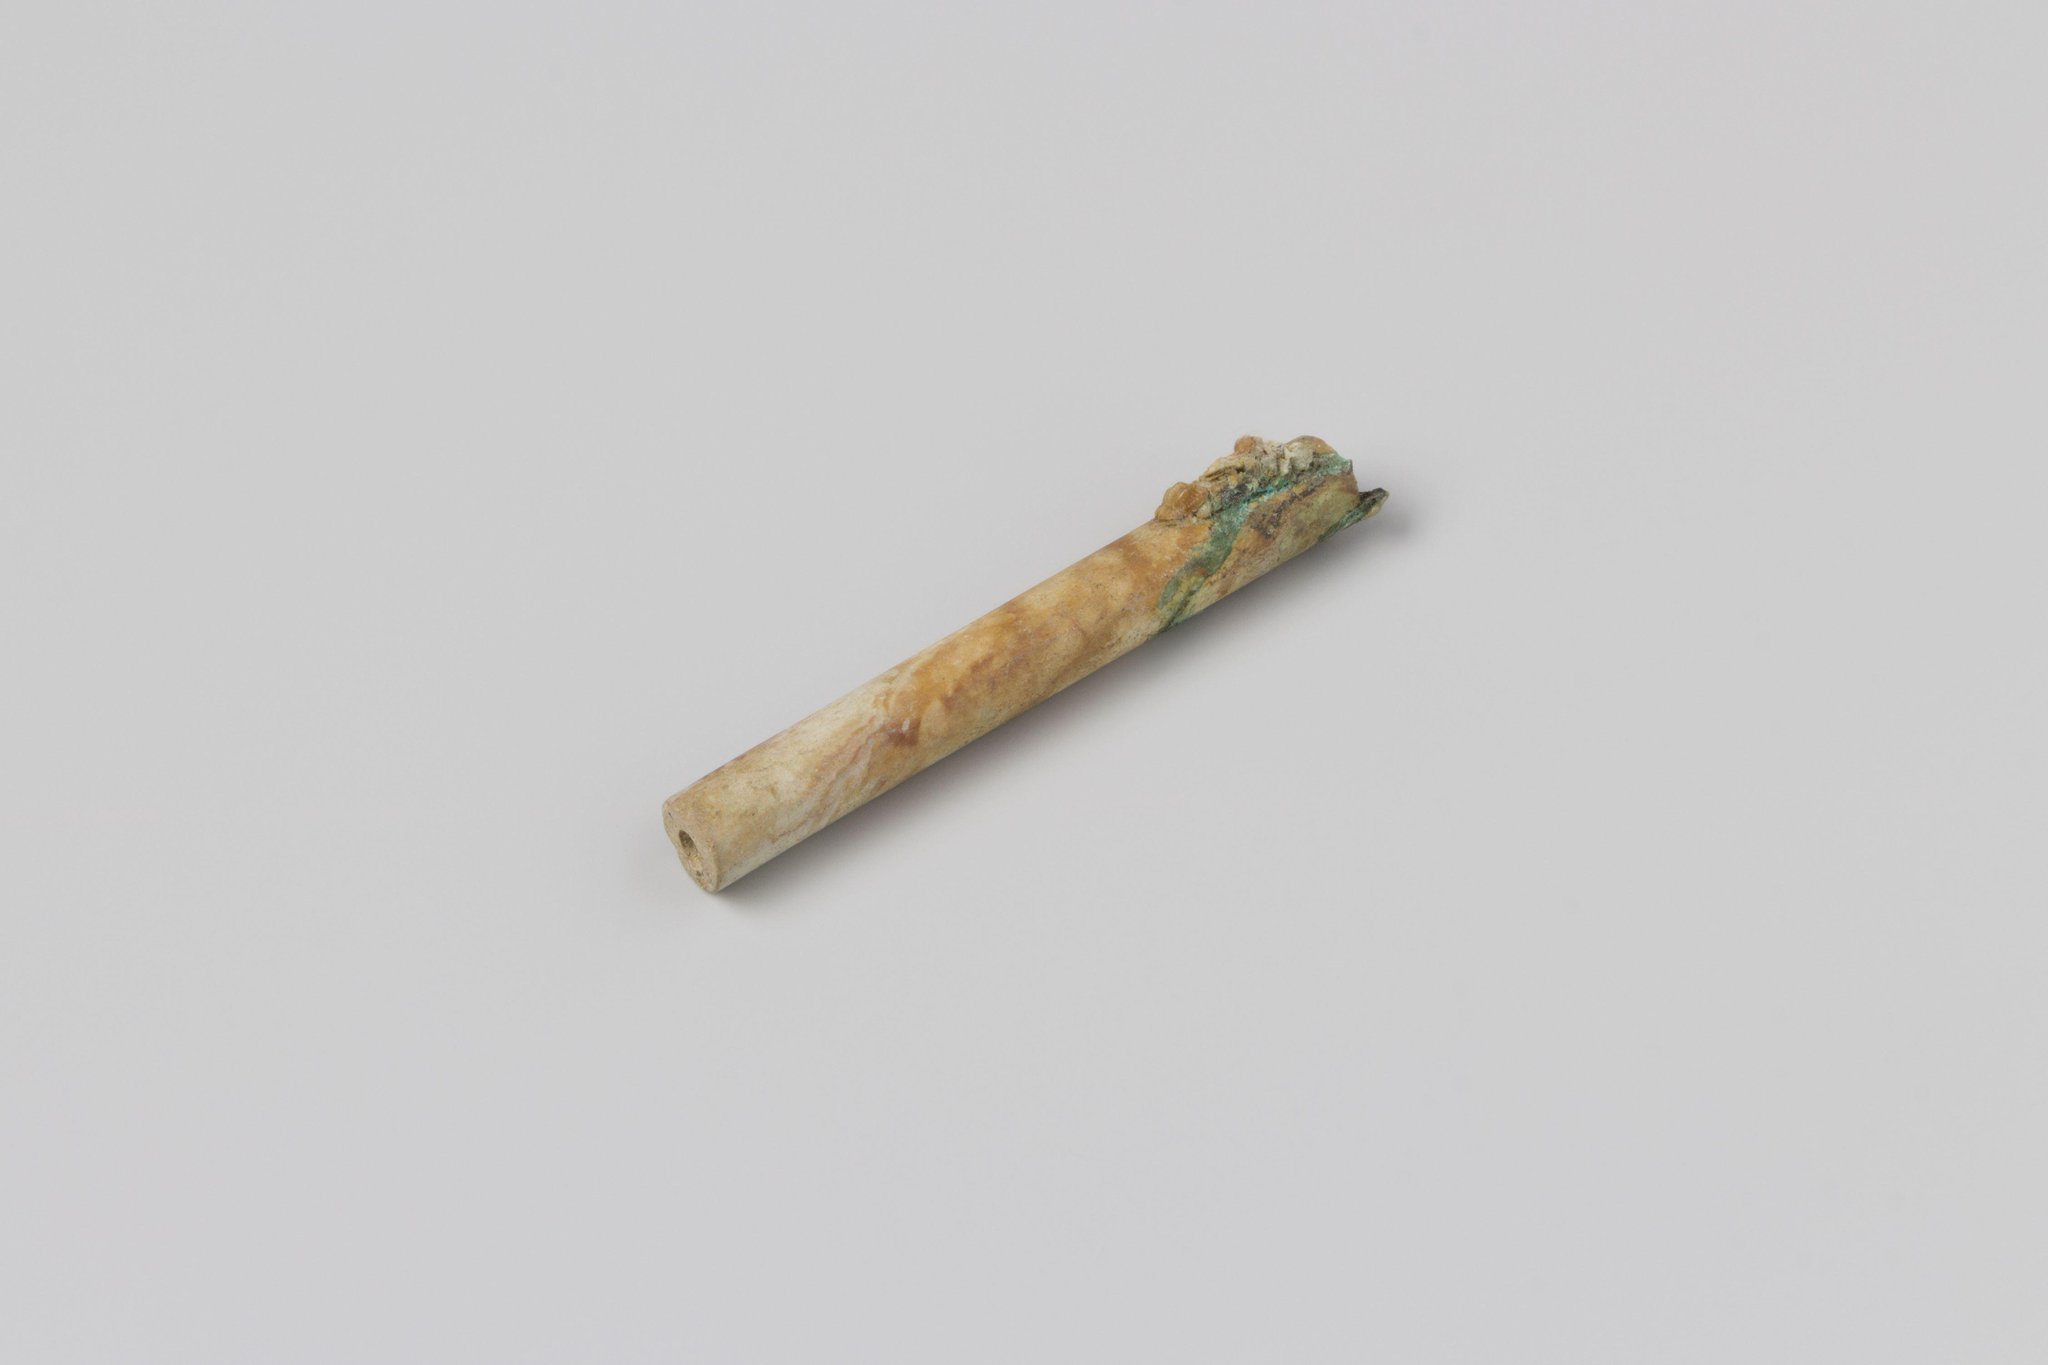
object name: pipe stem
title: Fragment pijpensteel uit het wrak van de Oost-Indiëvaarder Hollandia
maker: Anonymous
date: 1700-1743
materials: clay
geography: netherlands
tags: verenigde oostindische compagnie, hollandia (schip), annet